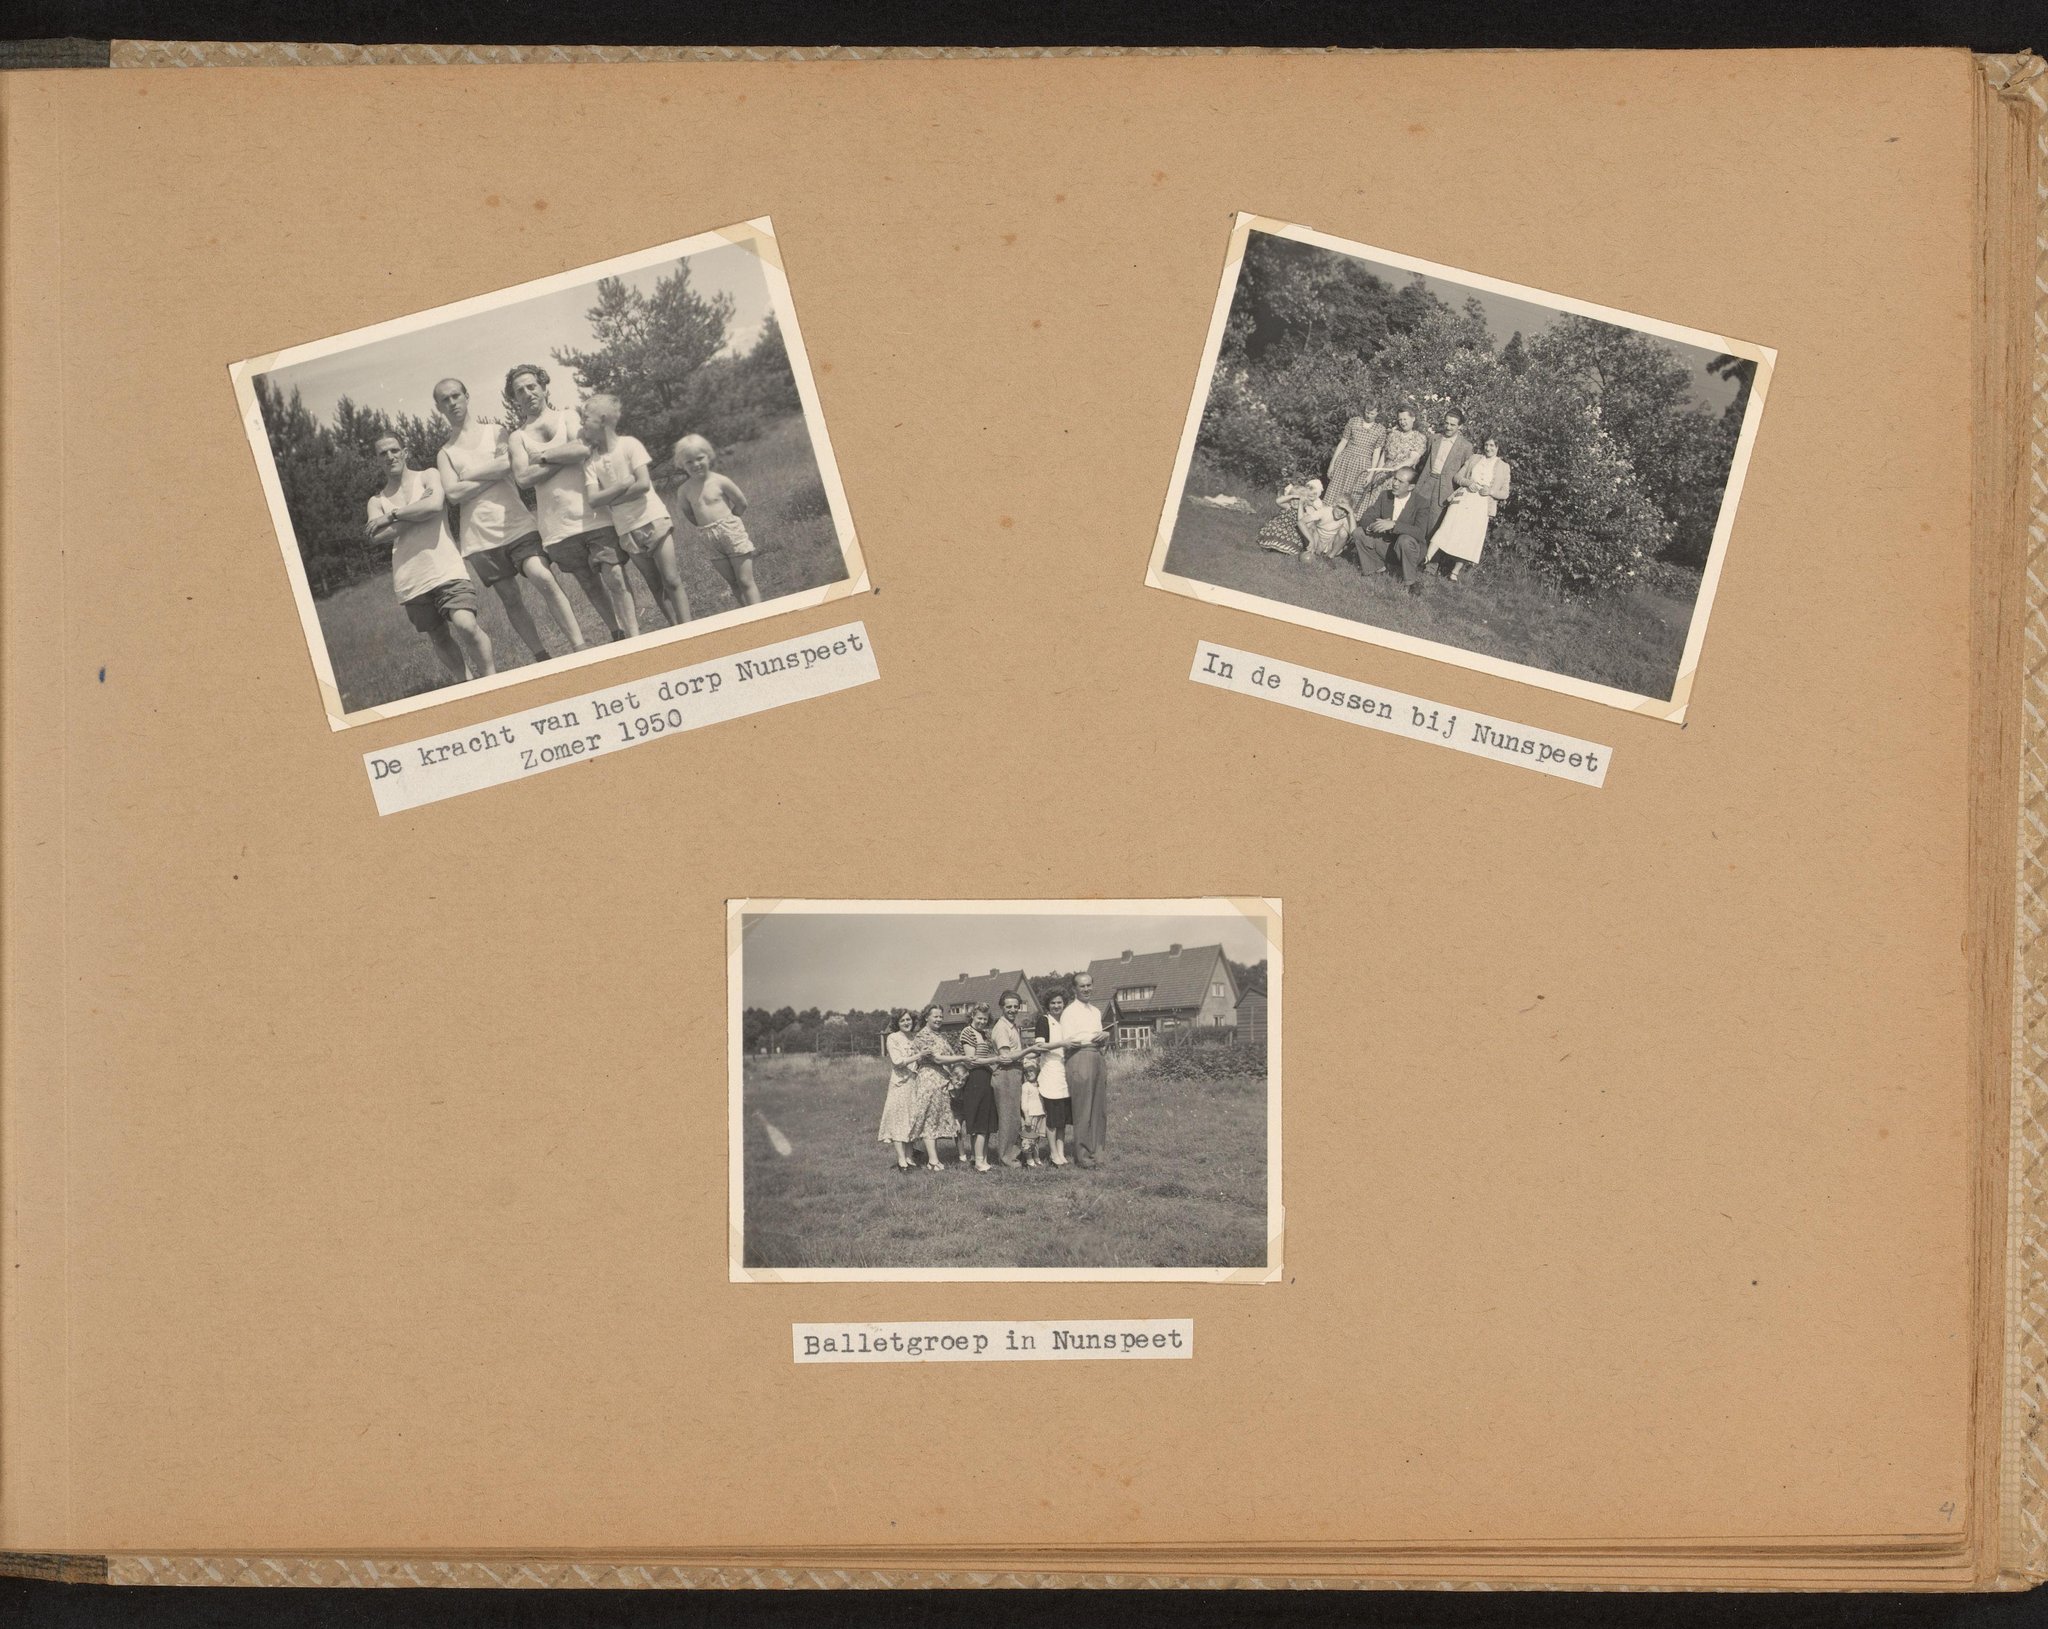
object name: photograph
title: Nunspeet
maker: Anonymous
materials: paper, photographic support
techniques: gelatin silver print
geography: netherlands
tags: the family travelling, on holiday, outing, pleasure trip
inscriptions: inscription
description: Albumblad met vier foto's van een vakantie met het gezin in Nunspeet, zomer 1950. Onder de foto's uitgeknipte papiertjes met getypte opschriften. Onderdeel van het tweede fotoalbum met foto's van familievakanties in Nederland, België, Luxemburg en Frankrijk in 1950-1951.